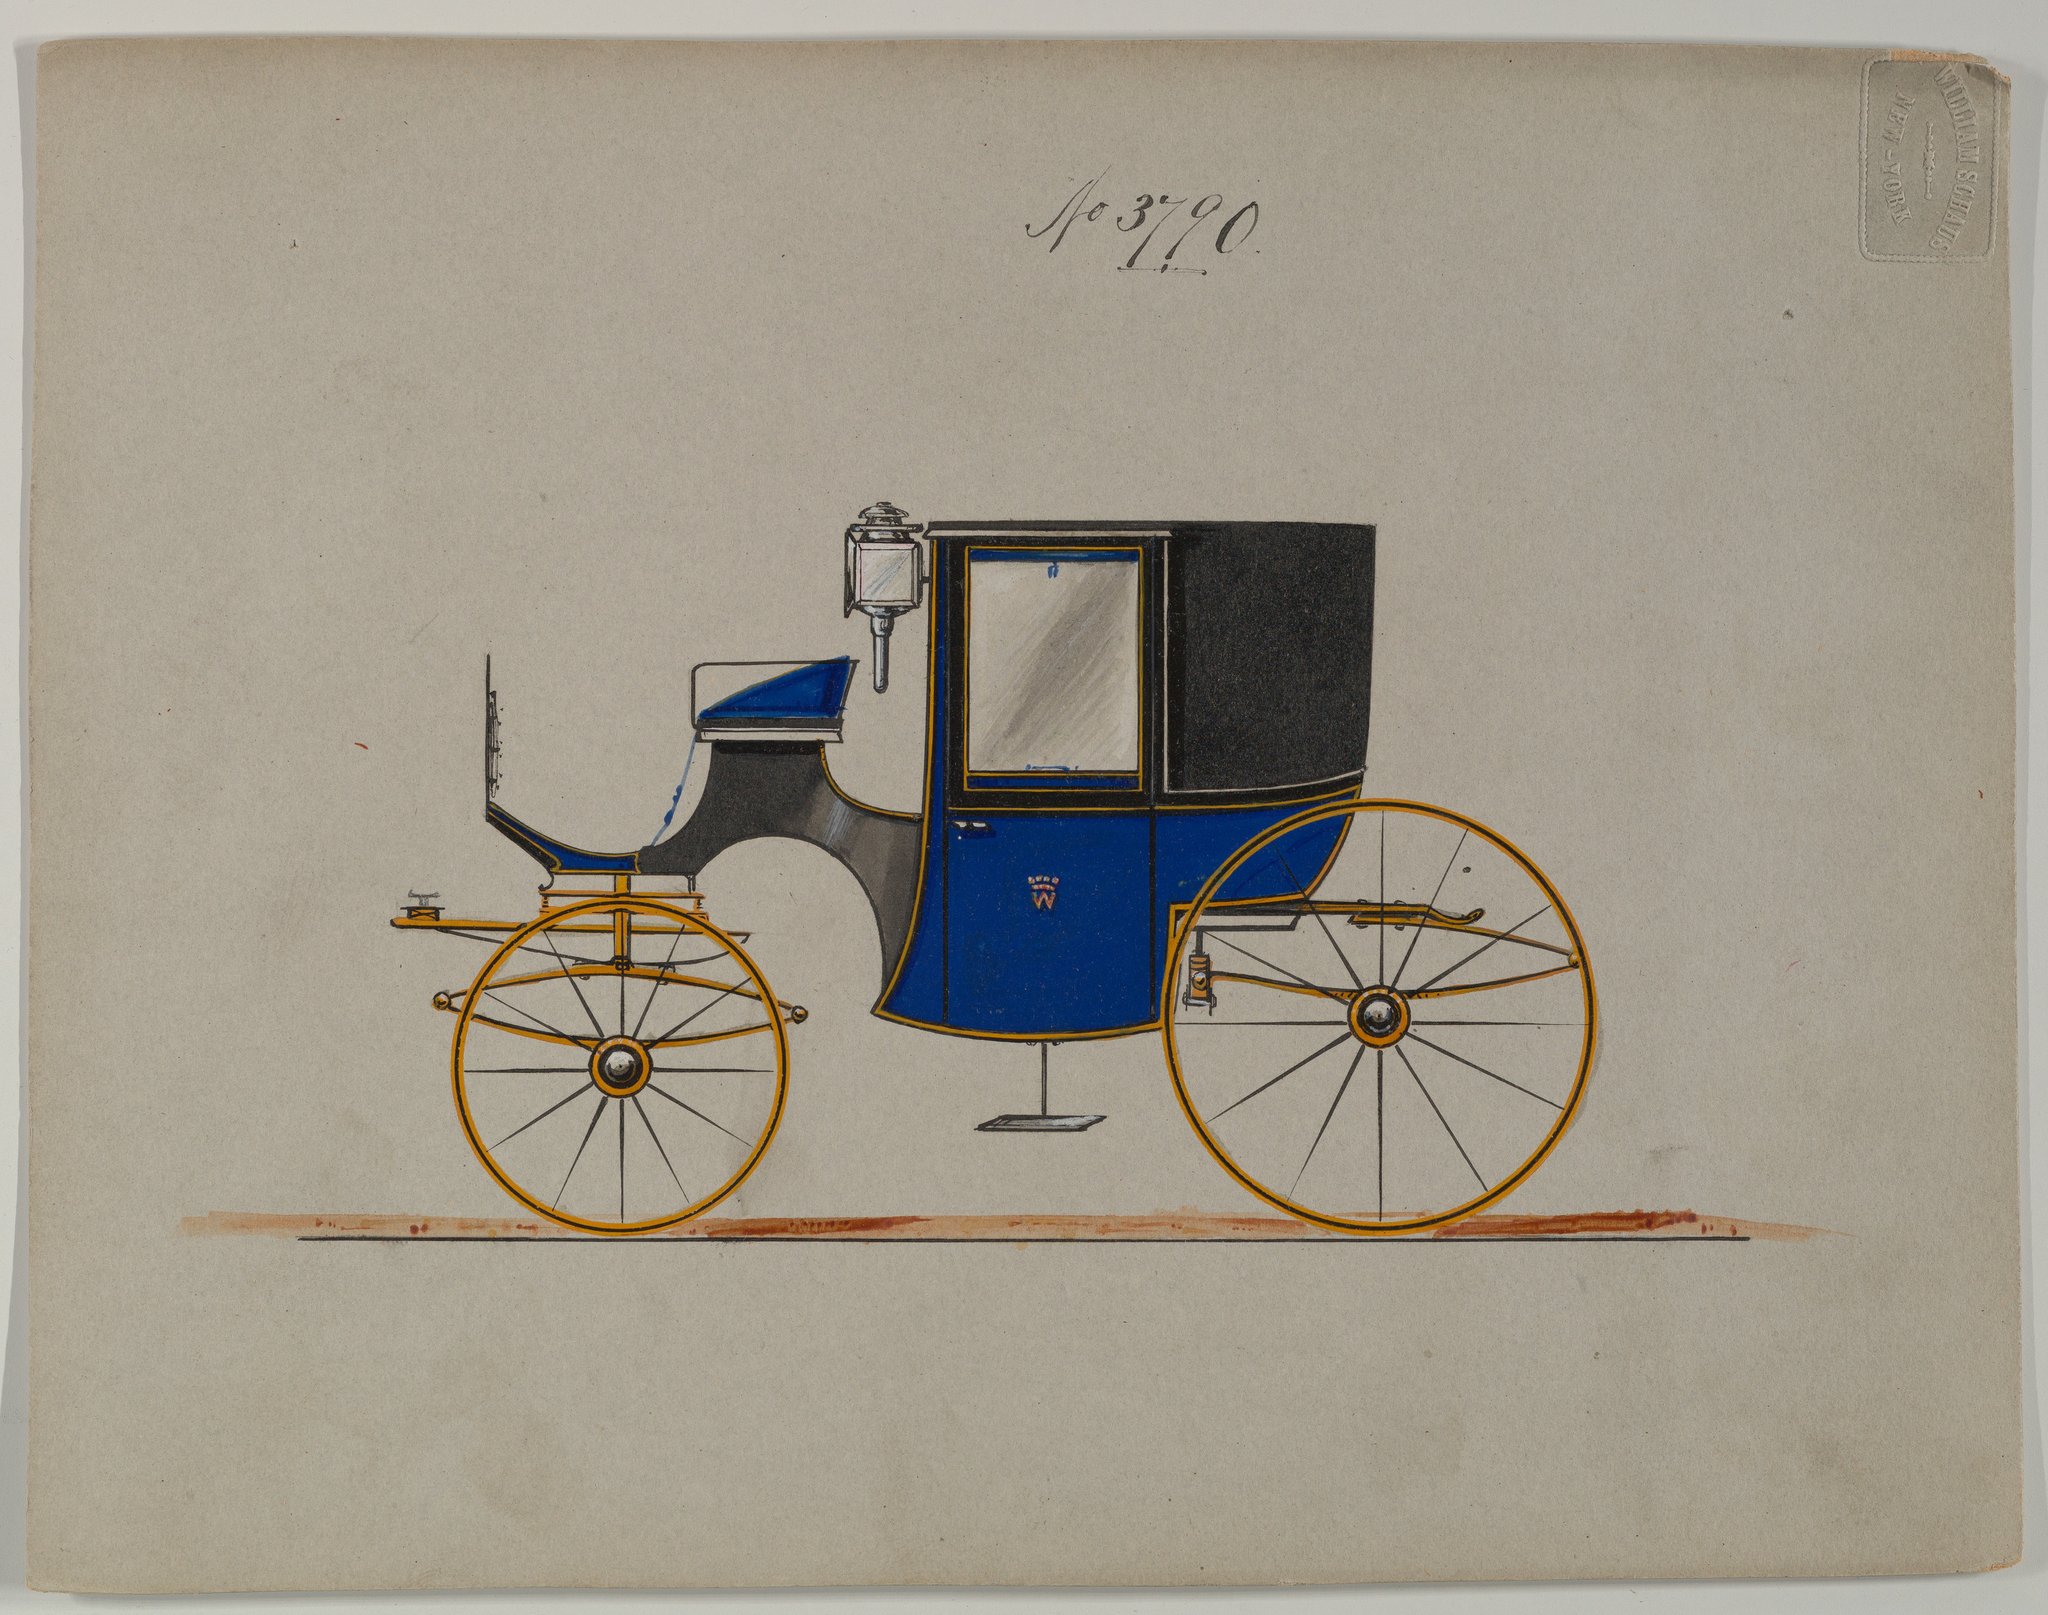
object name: drawing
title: Brougham #3790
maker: brewster & co.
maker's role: manufacturer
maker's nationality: american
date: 1882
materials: gouache, gum arabic, ink, watercolor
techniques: pen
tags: carriages